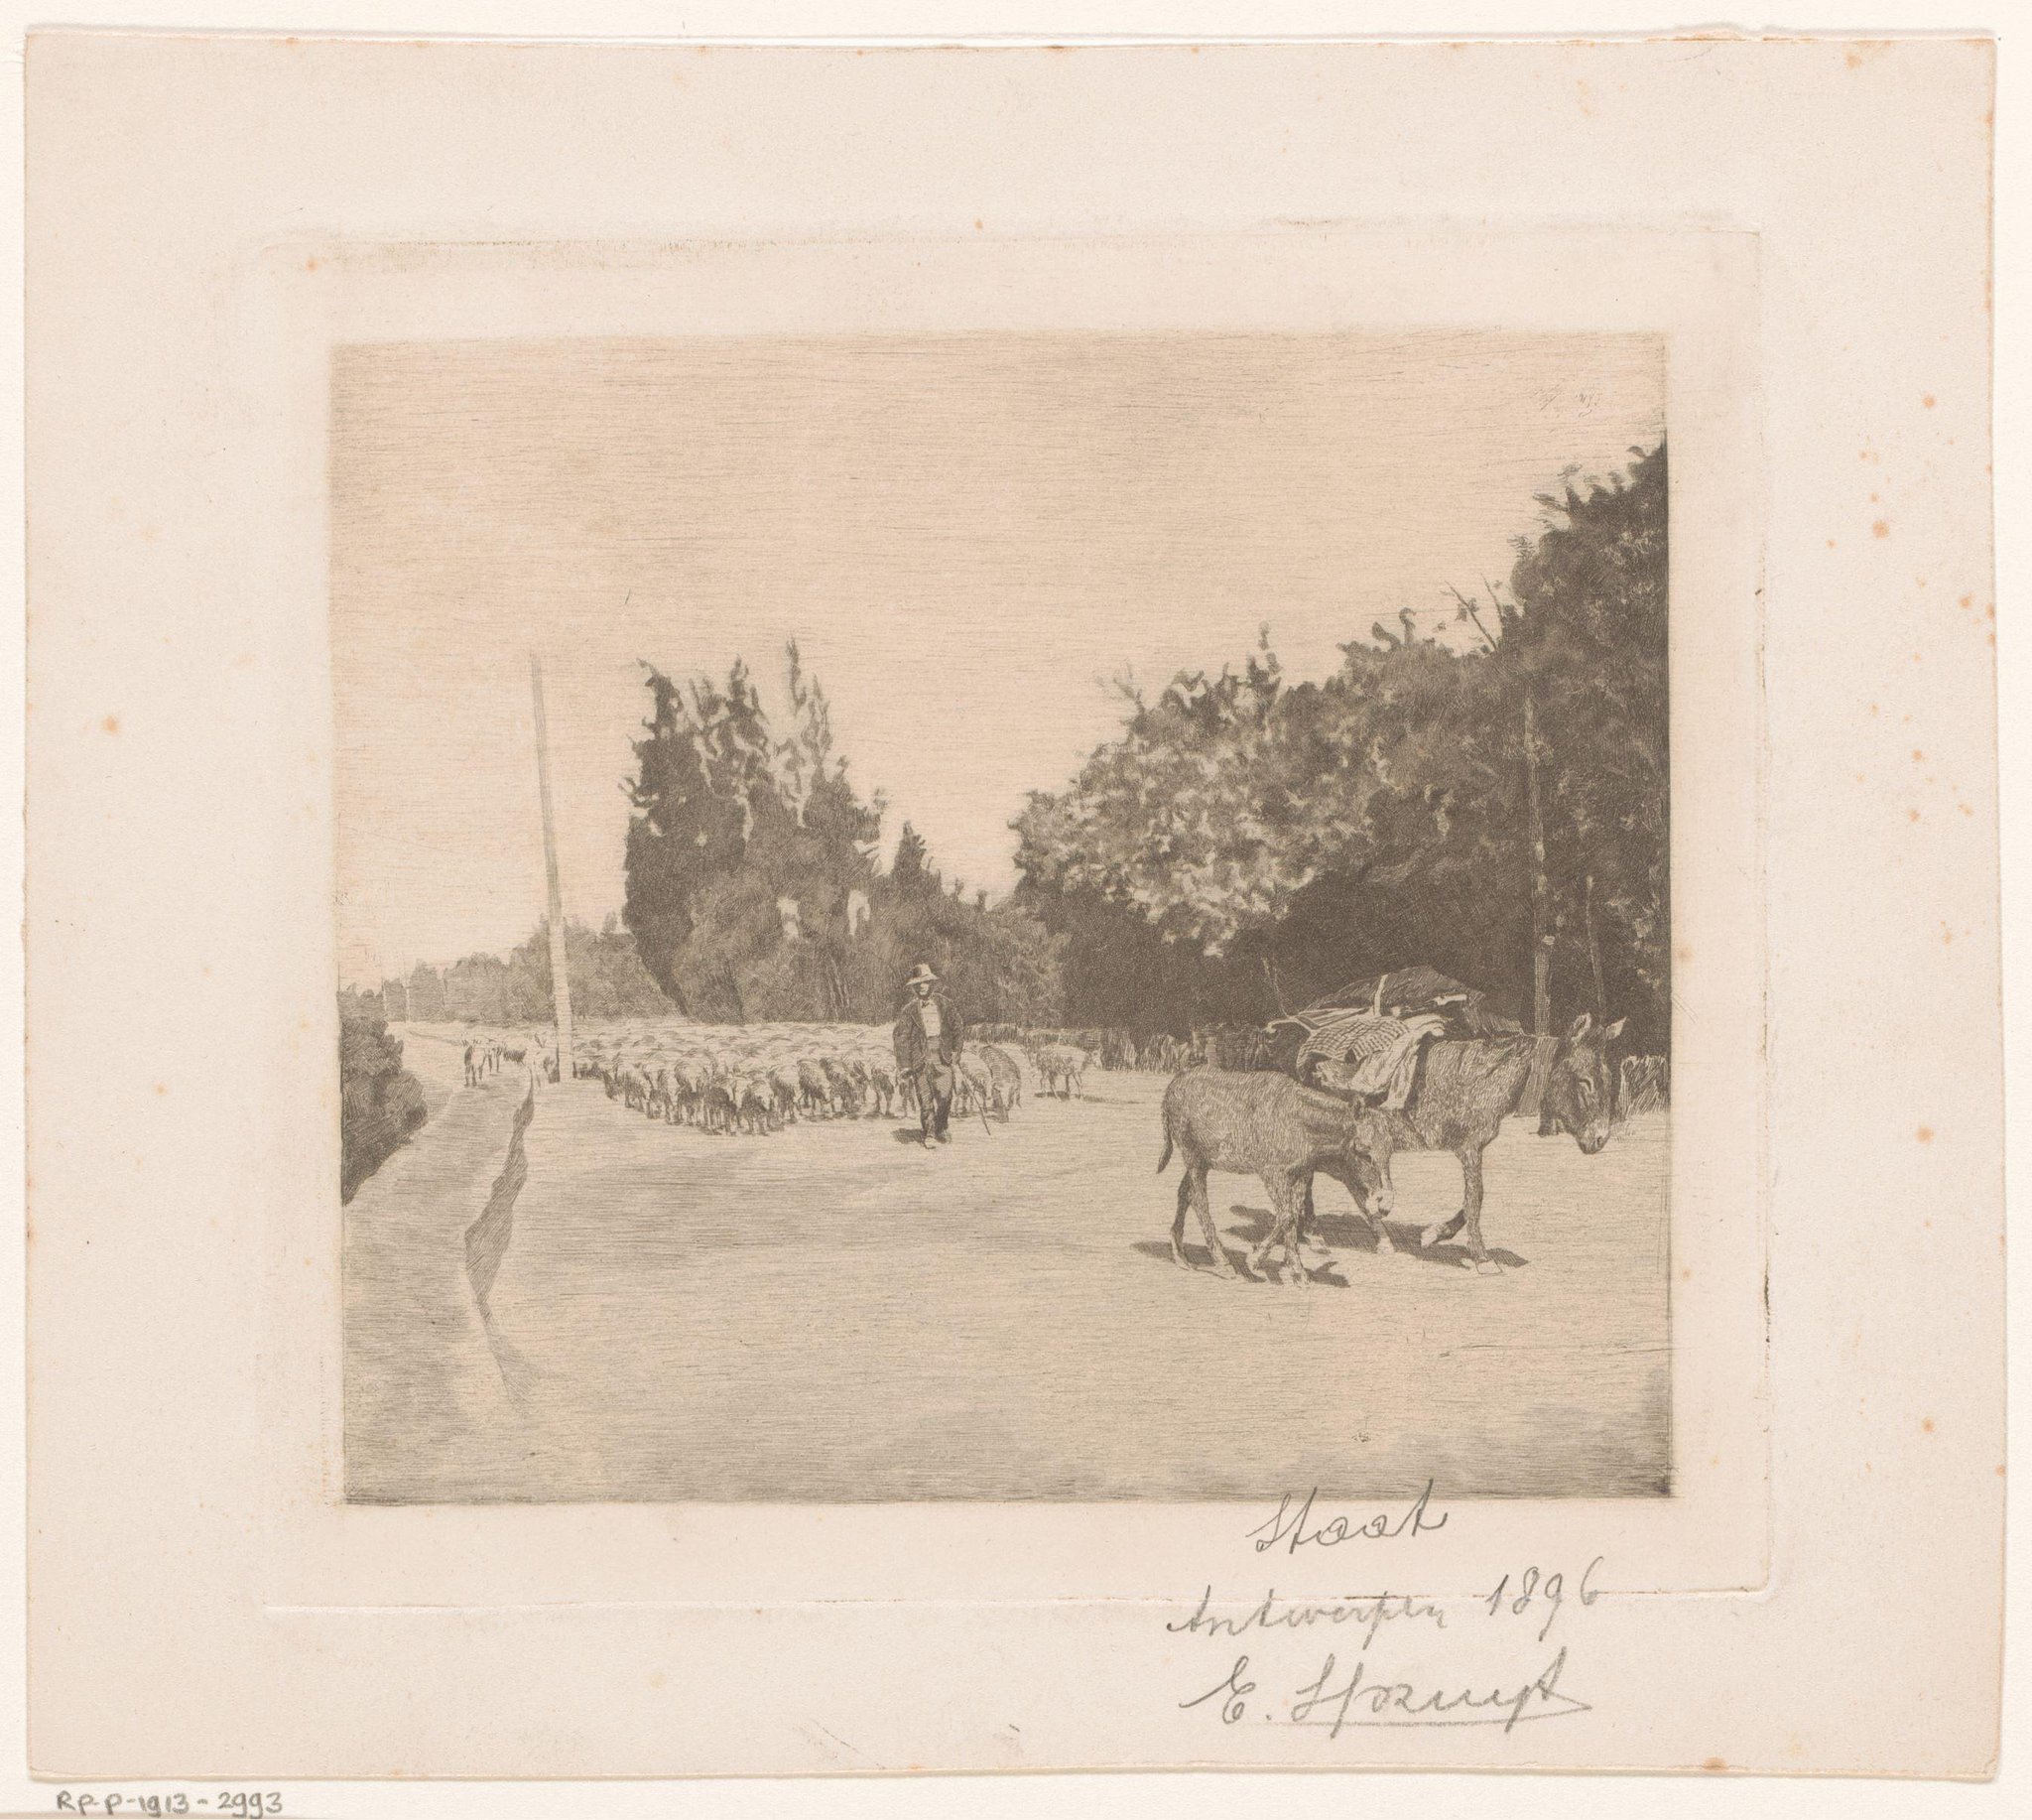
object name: print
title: Herder met kudde schapen en twee ezels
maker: emile pierre maria spruyt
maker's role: print maker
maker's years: 1870-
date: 1896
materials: paper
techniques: etching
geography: antwerp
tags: ass, donkey, sheep, herd, flock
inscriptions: collector's mark: Lugt 2228, inscription: ‘Staat Antwerpen 1896’